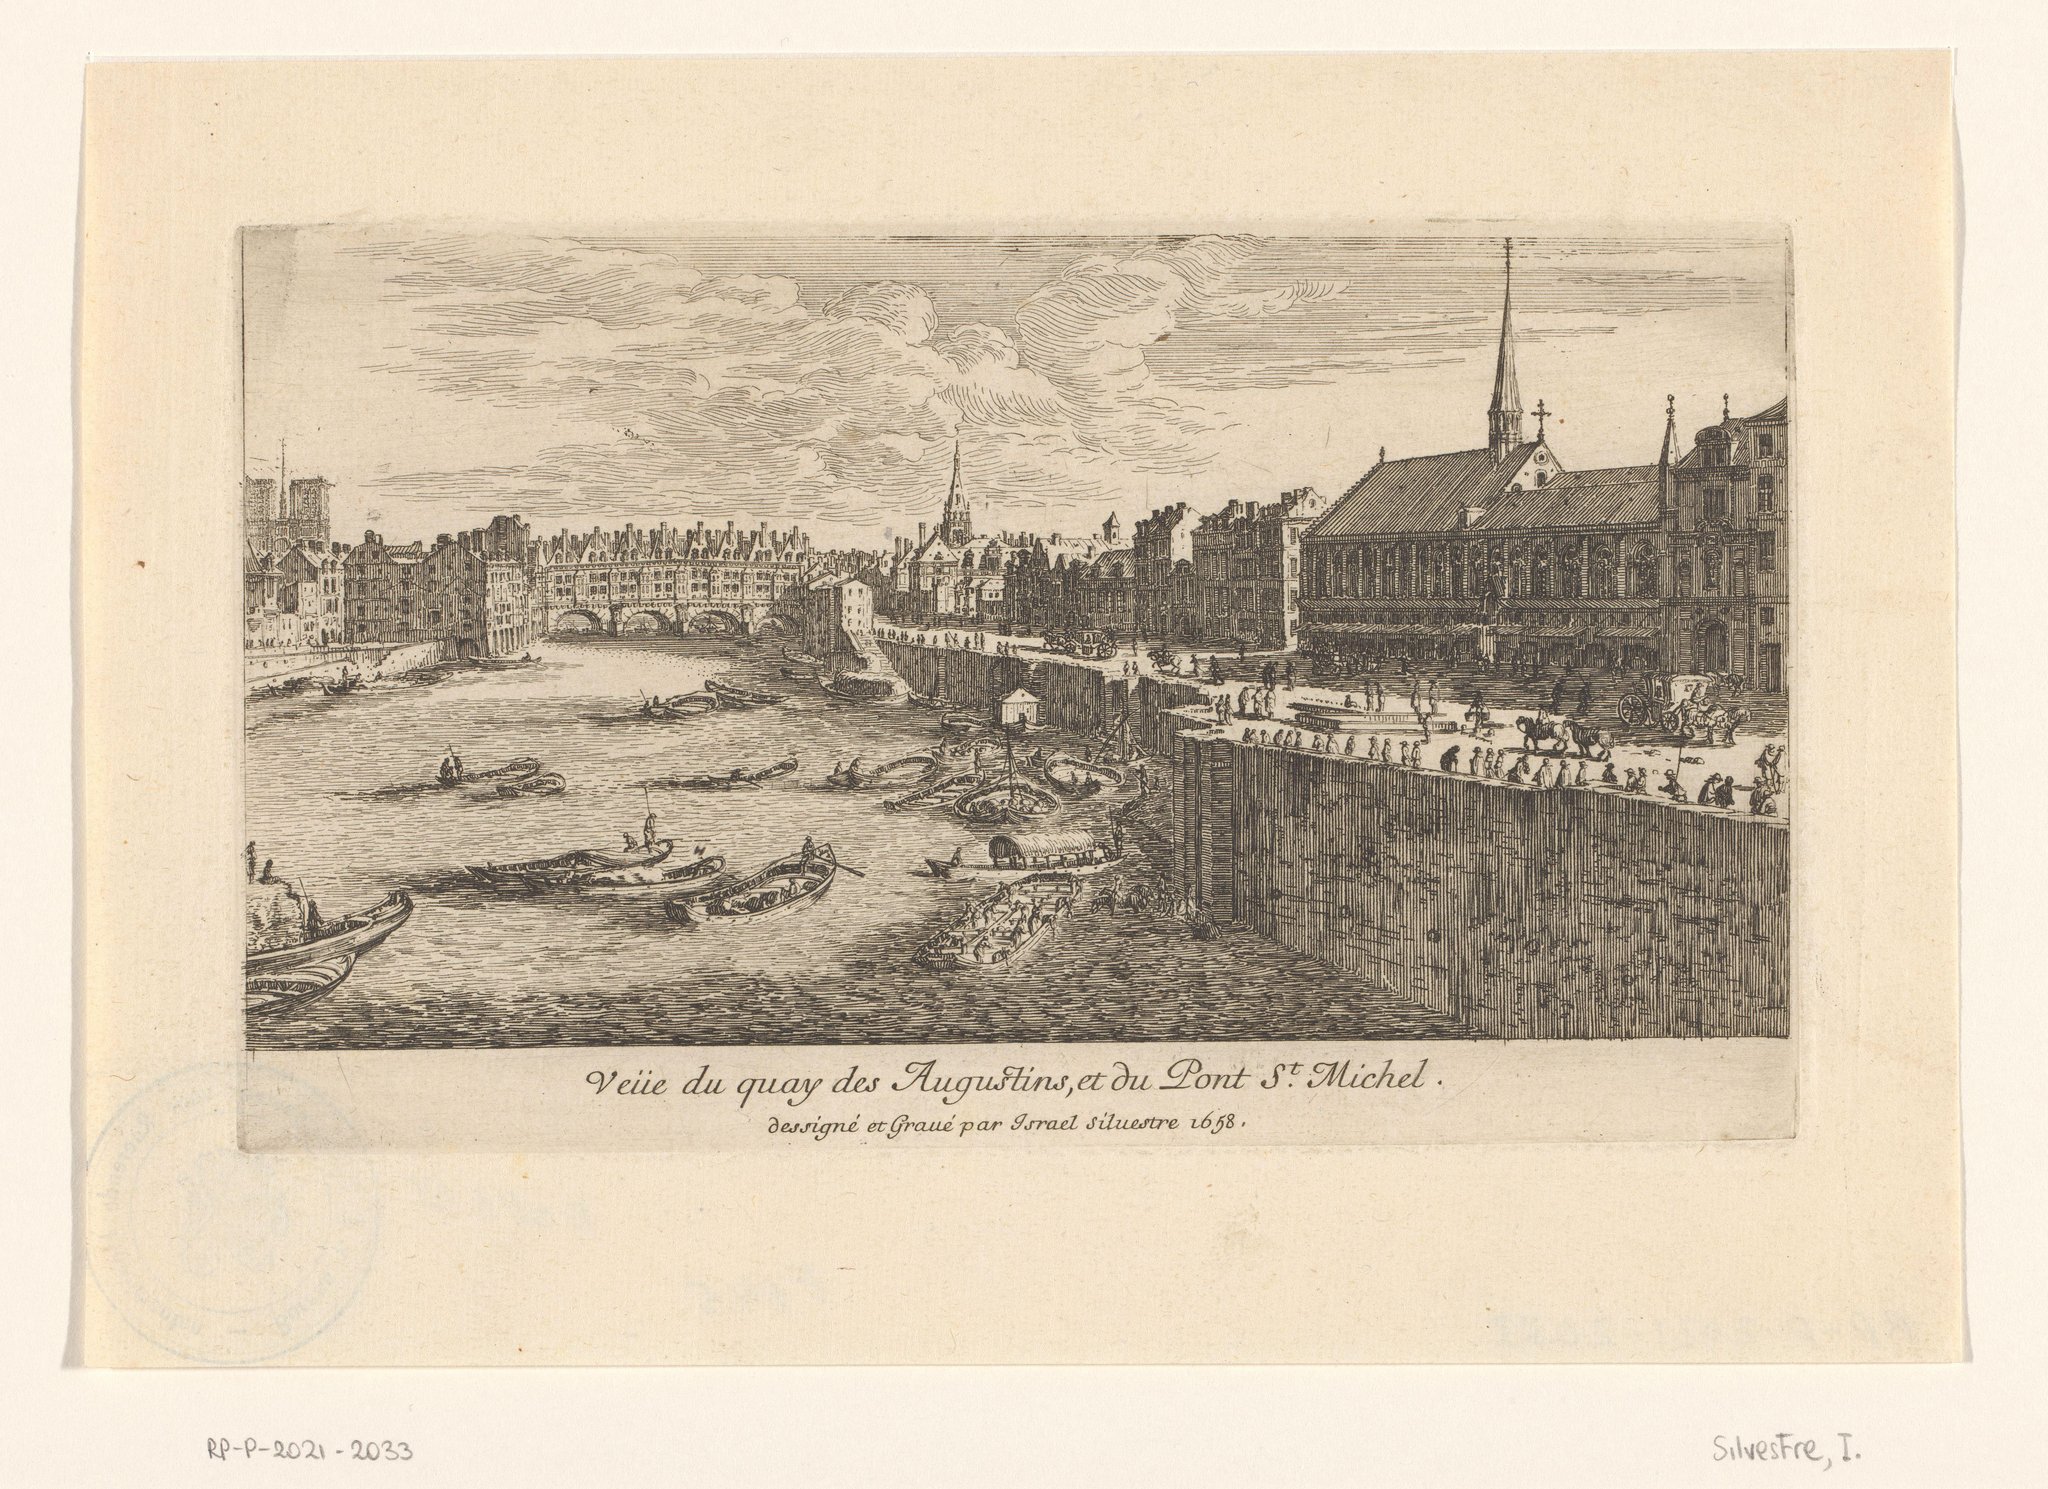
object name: print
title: Gezicht op de Seine met de Pont Saint-Michel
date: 1658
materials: paper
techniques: etching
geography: france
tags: bridge in city across river, canal, etc. (+ city(-scape) with figures, staffage), church (exterior), rowing-boat, canoe, etc.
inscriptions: stamp: ‘Bureau v.d. Rijksinspecteur voor Roerende Monumenten ’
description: Prent maakt deel uit van een ongenummerde serie van tien prenten.